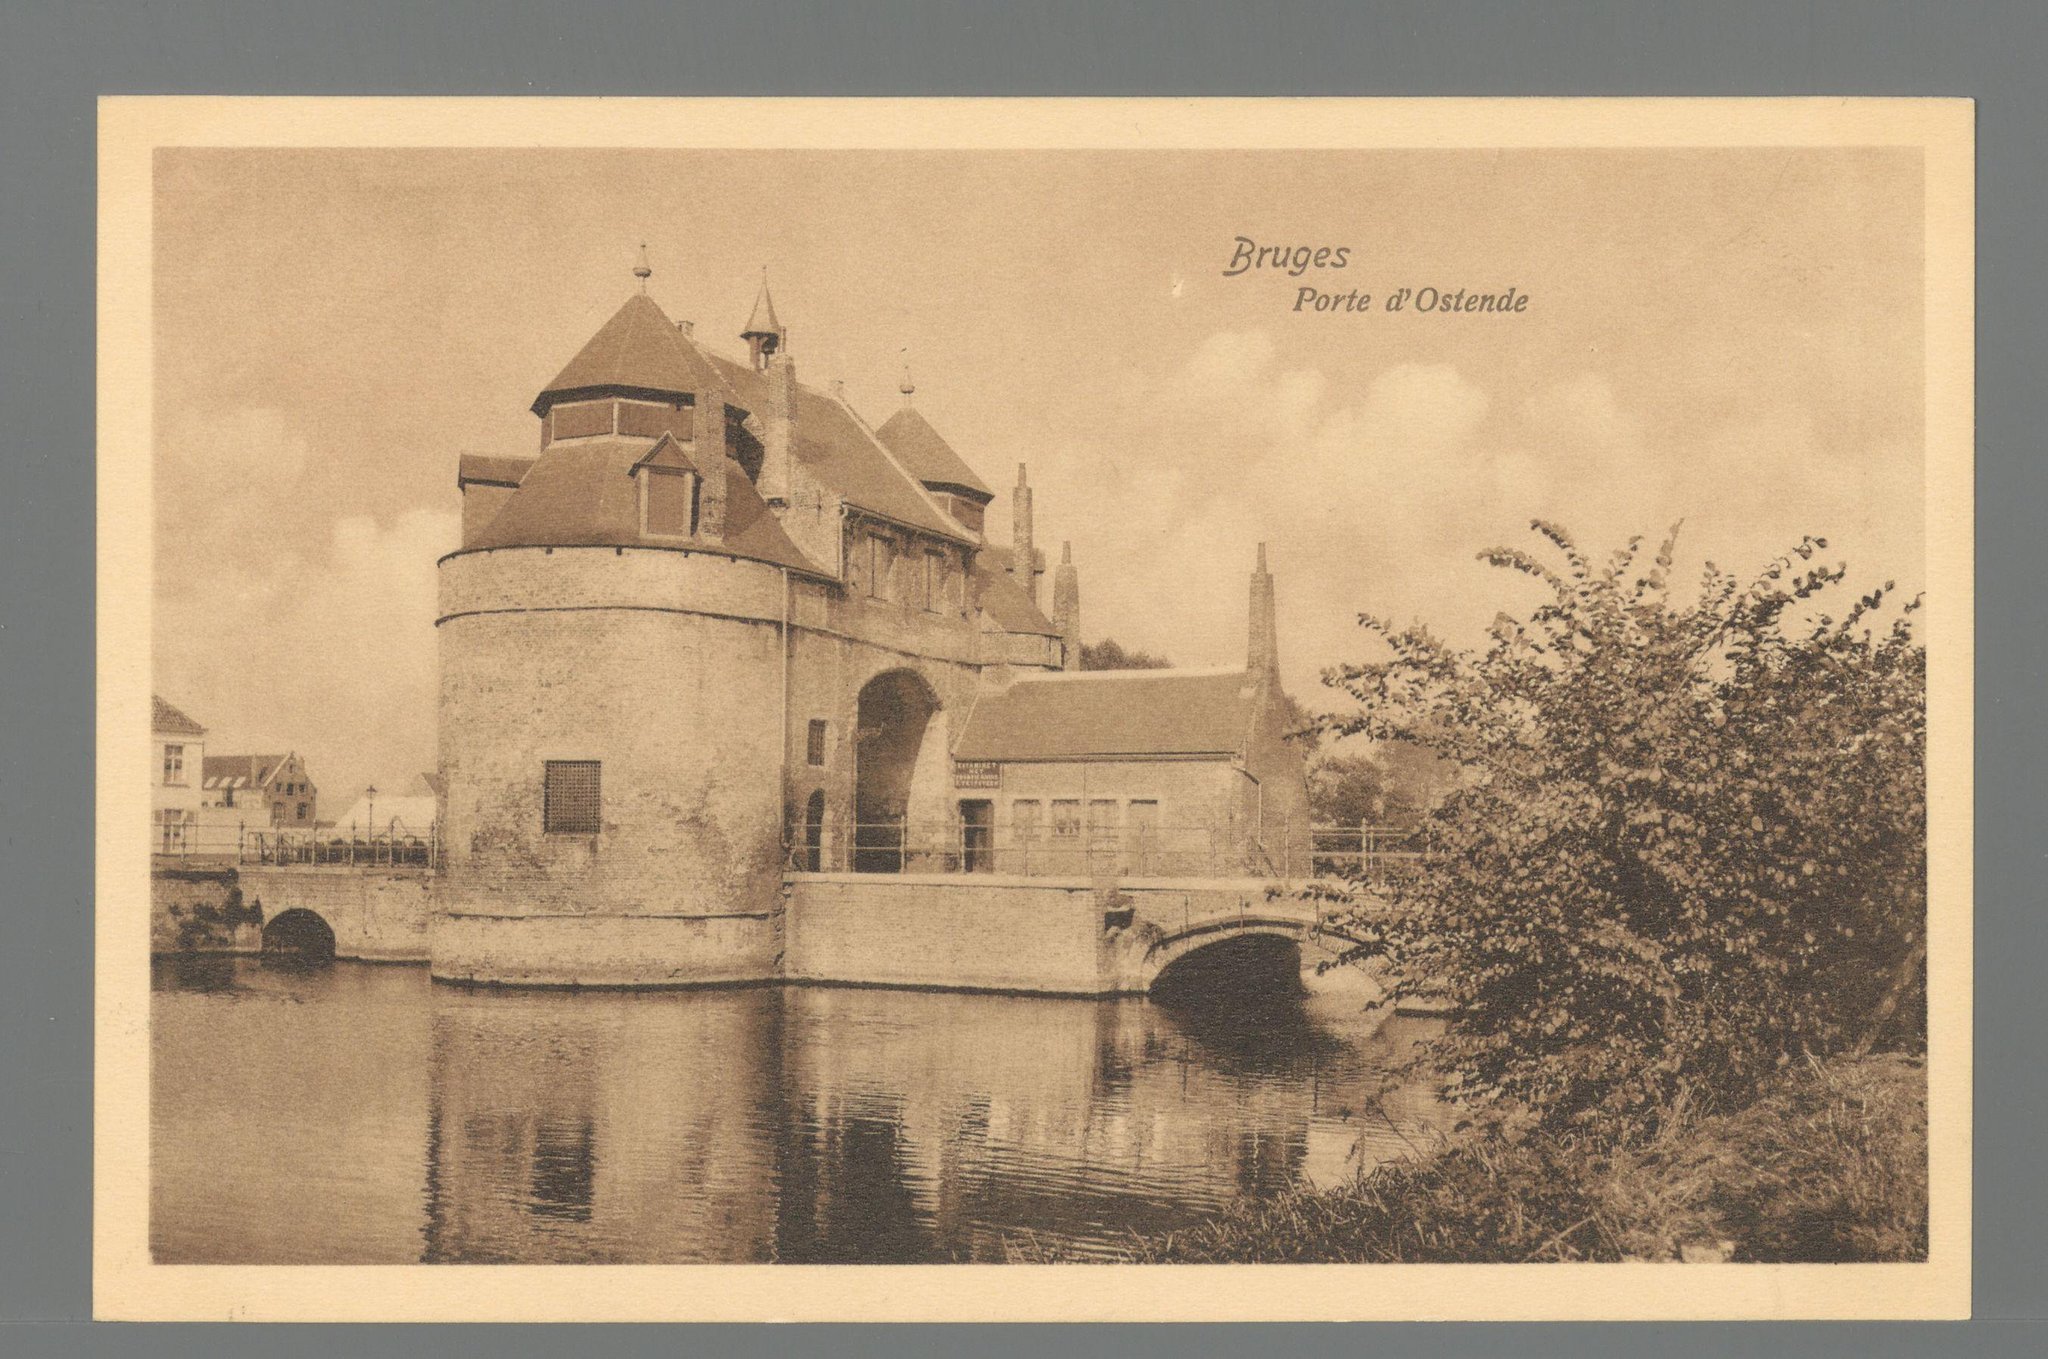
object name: ansichtkaart, prentbriefkaart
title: Bruges. Porte d'Ostende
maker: Anonymous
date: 1906-1930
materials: cardboard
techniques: photograph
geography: bruges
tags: water course, gate, entrance, bruges